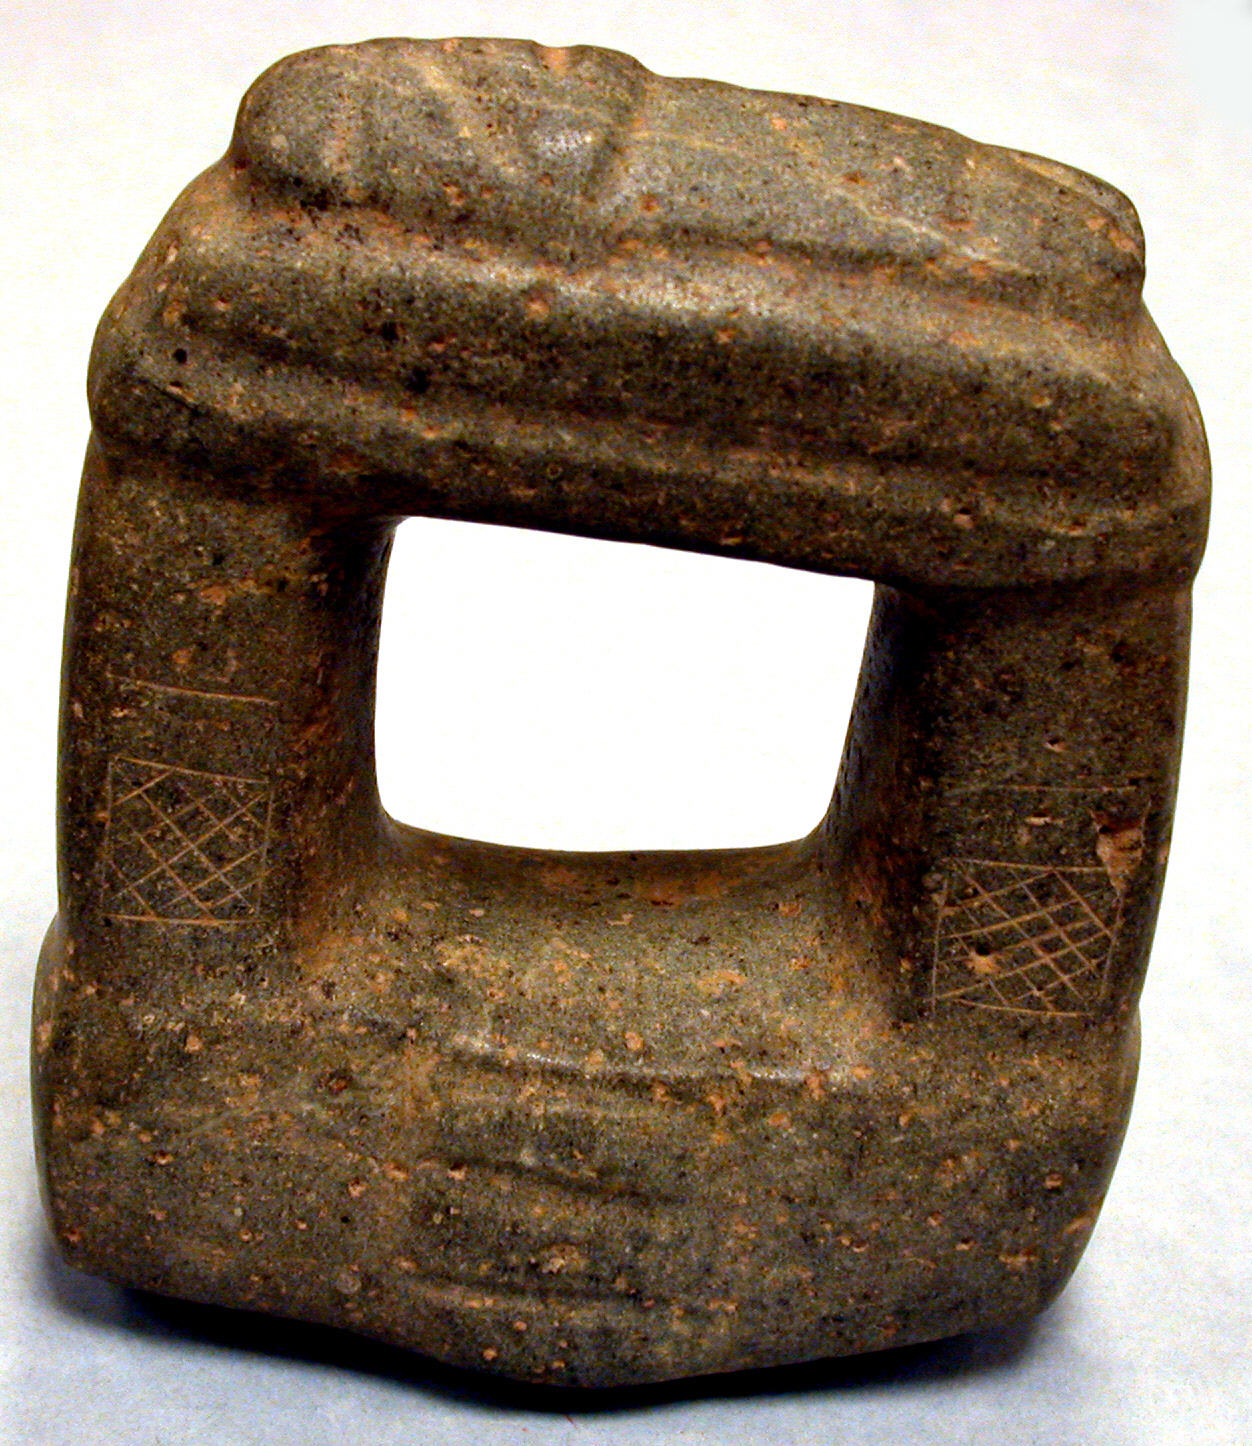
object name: architectural model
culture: mezcala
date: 1-800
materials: stone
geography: mexico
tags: temples